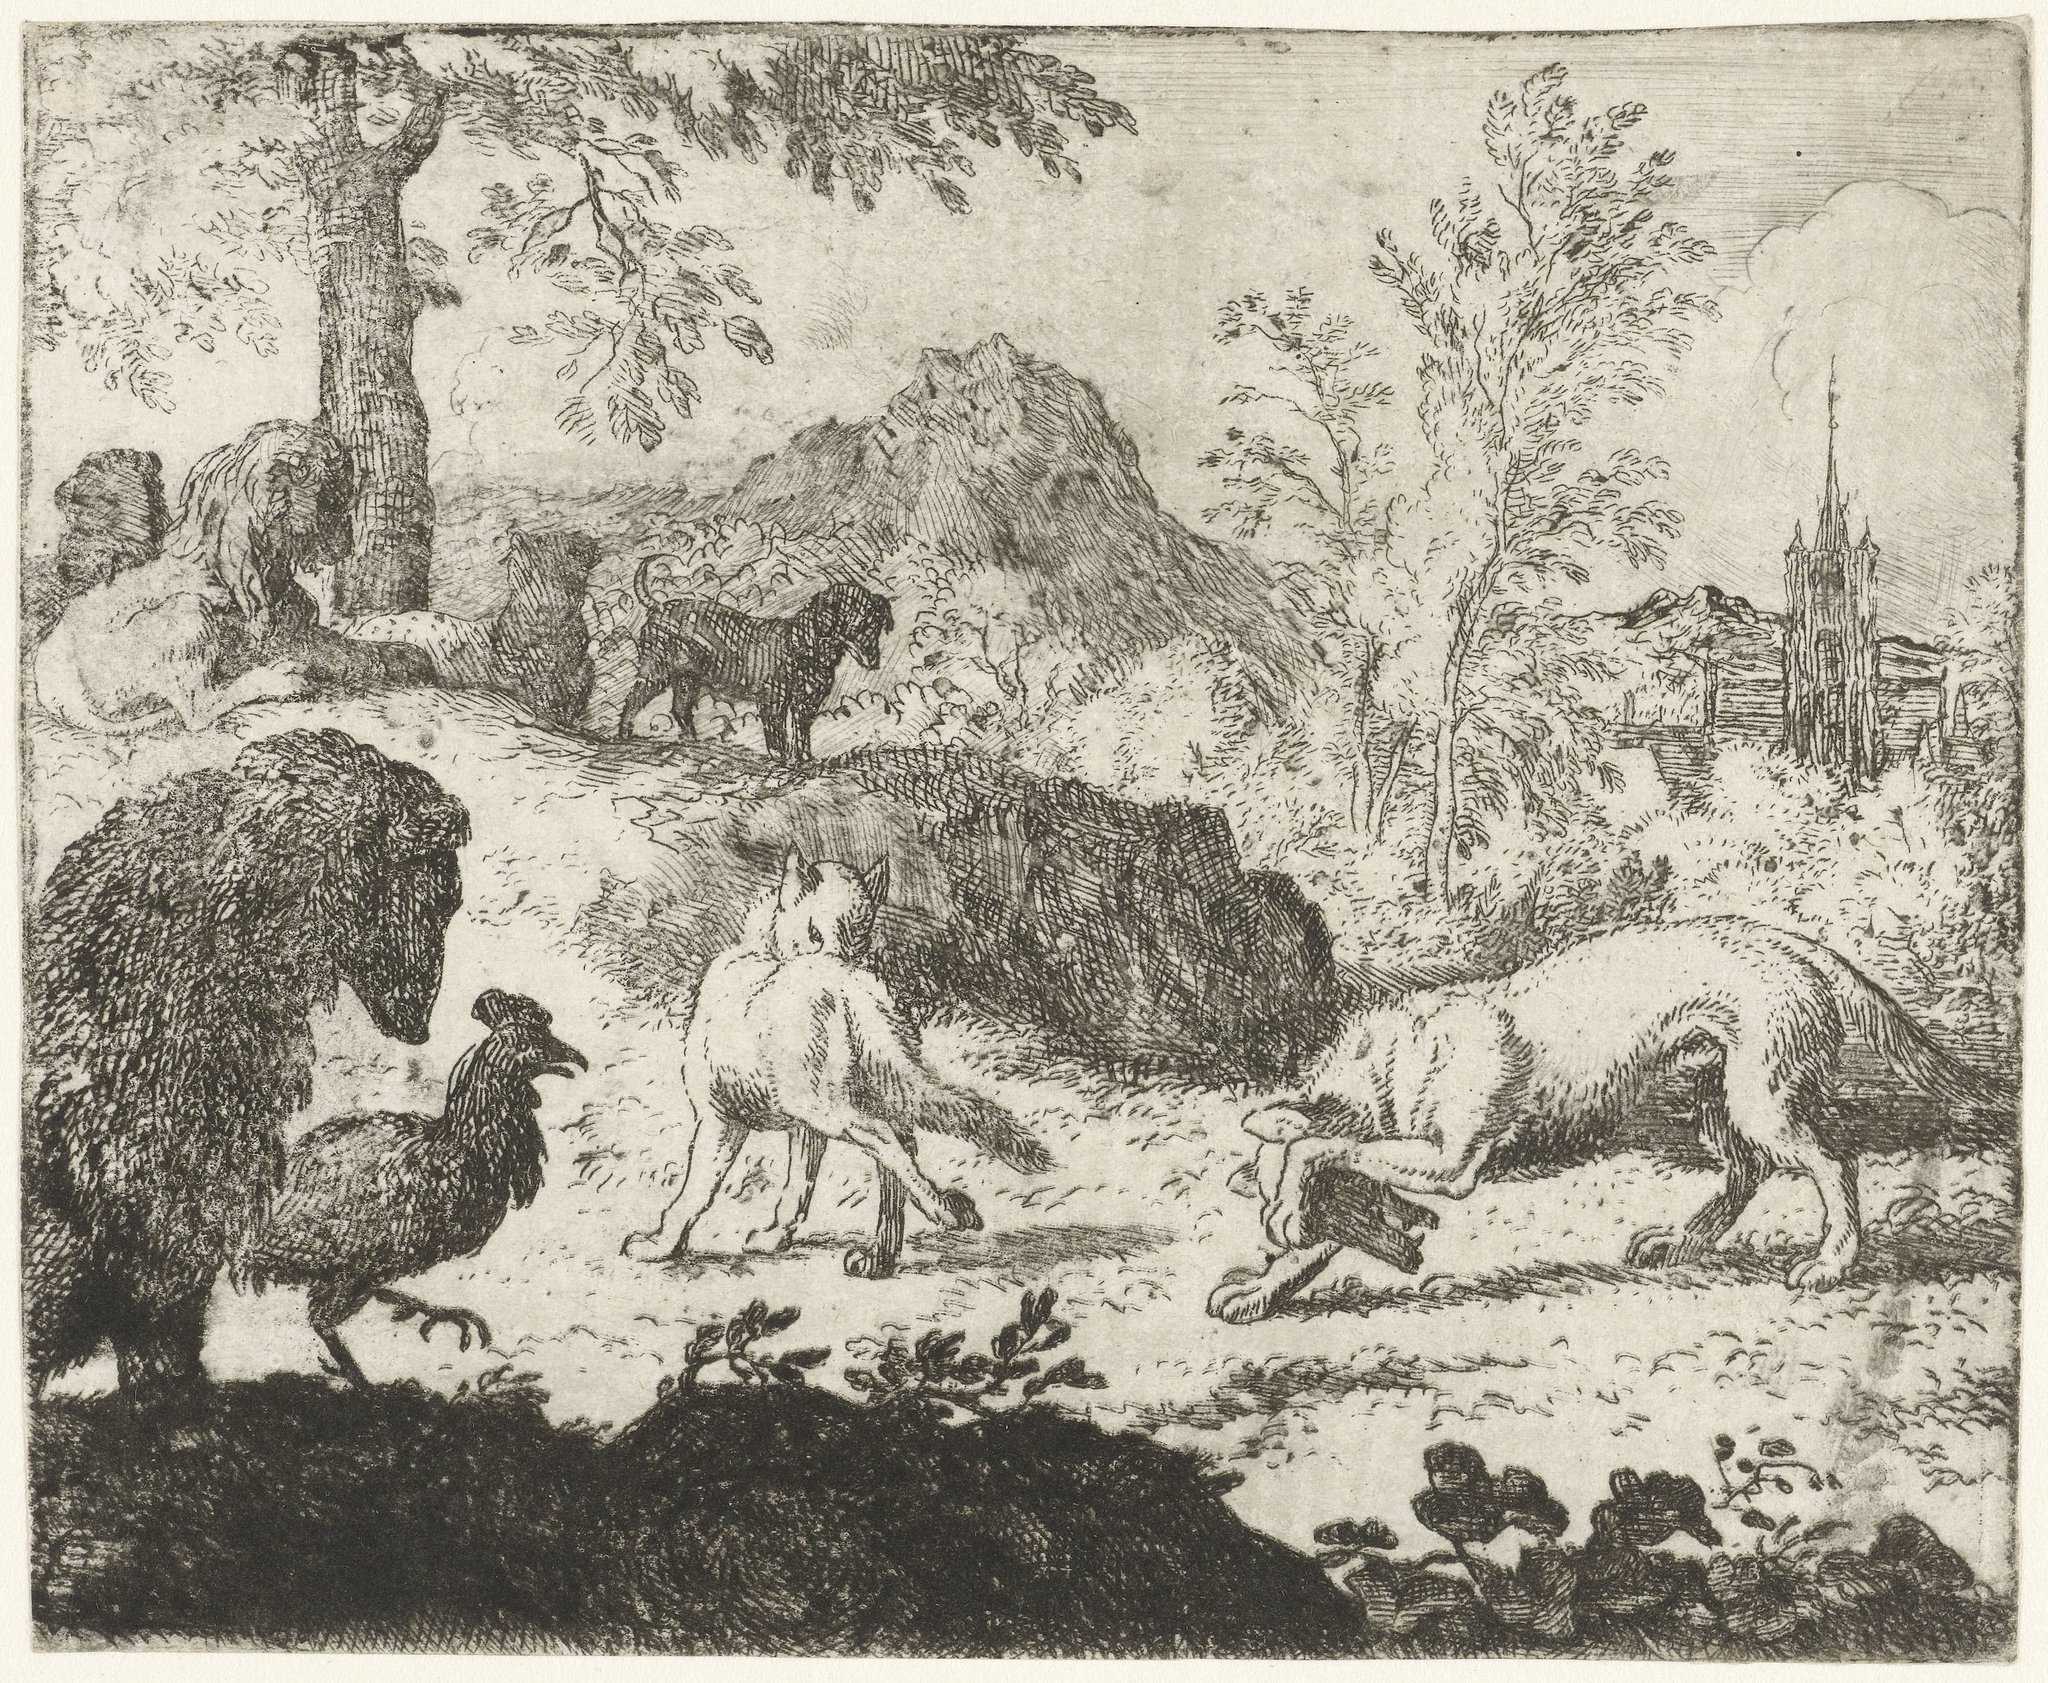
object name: print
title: Gevecht tussen Reinaert de vos en de wolf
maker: allaert van everdingen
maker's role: draughtsman, painter, print maker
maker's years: 1621-1675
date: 1665-1675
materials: paper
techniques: etching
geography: netherlands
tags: fable of reynard the fox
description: Reinaert de vos kijkt om naar de wolf die zijn poot bij zijn kop houdt. Bruun de beer en Cantclaer de haan kijken vanaf de voorgrond toe. Op de achtergrond zijn de andere dieren, waaronder de leeuw, koning Nobel, te zien.